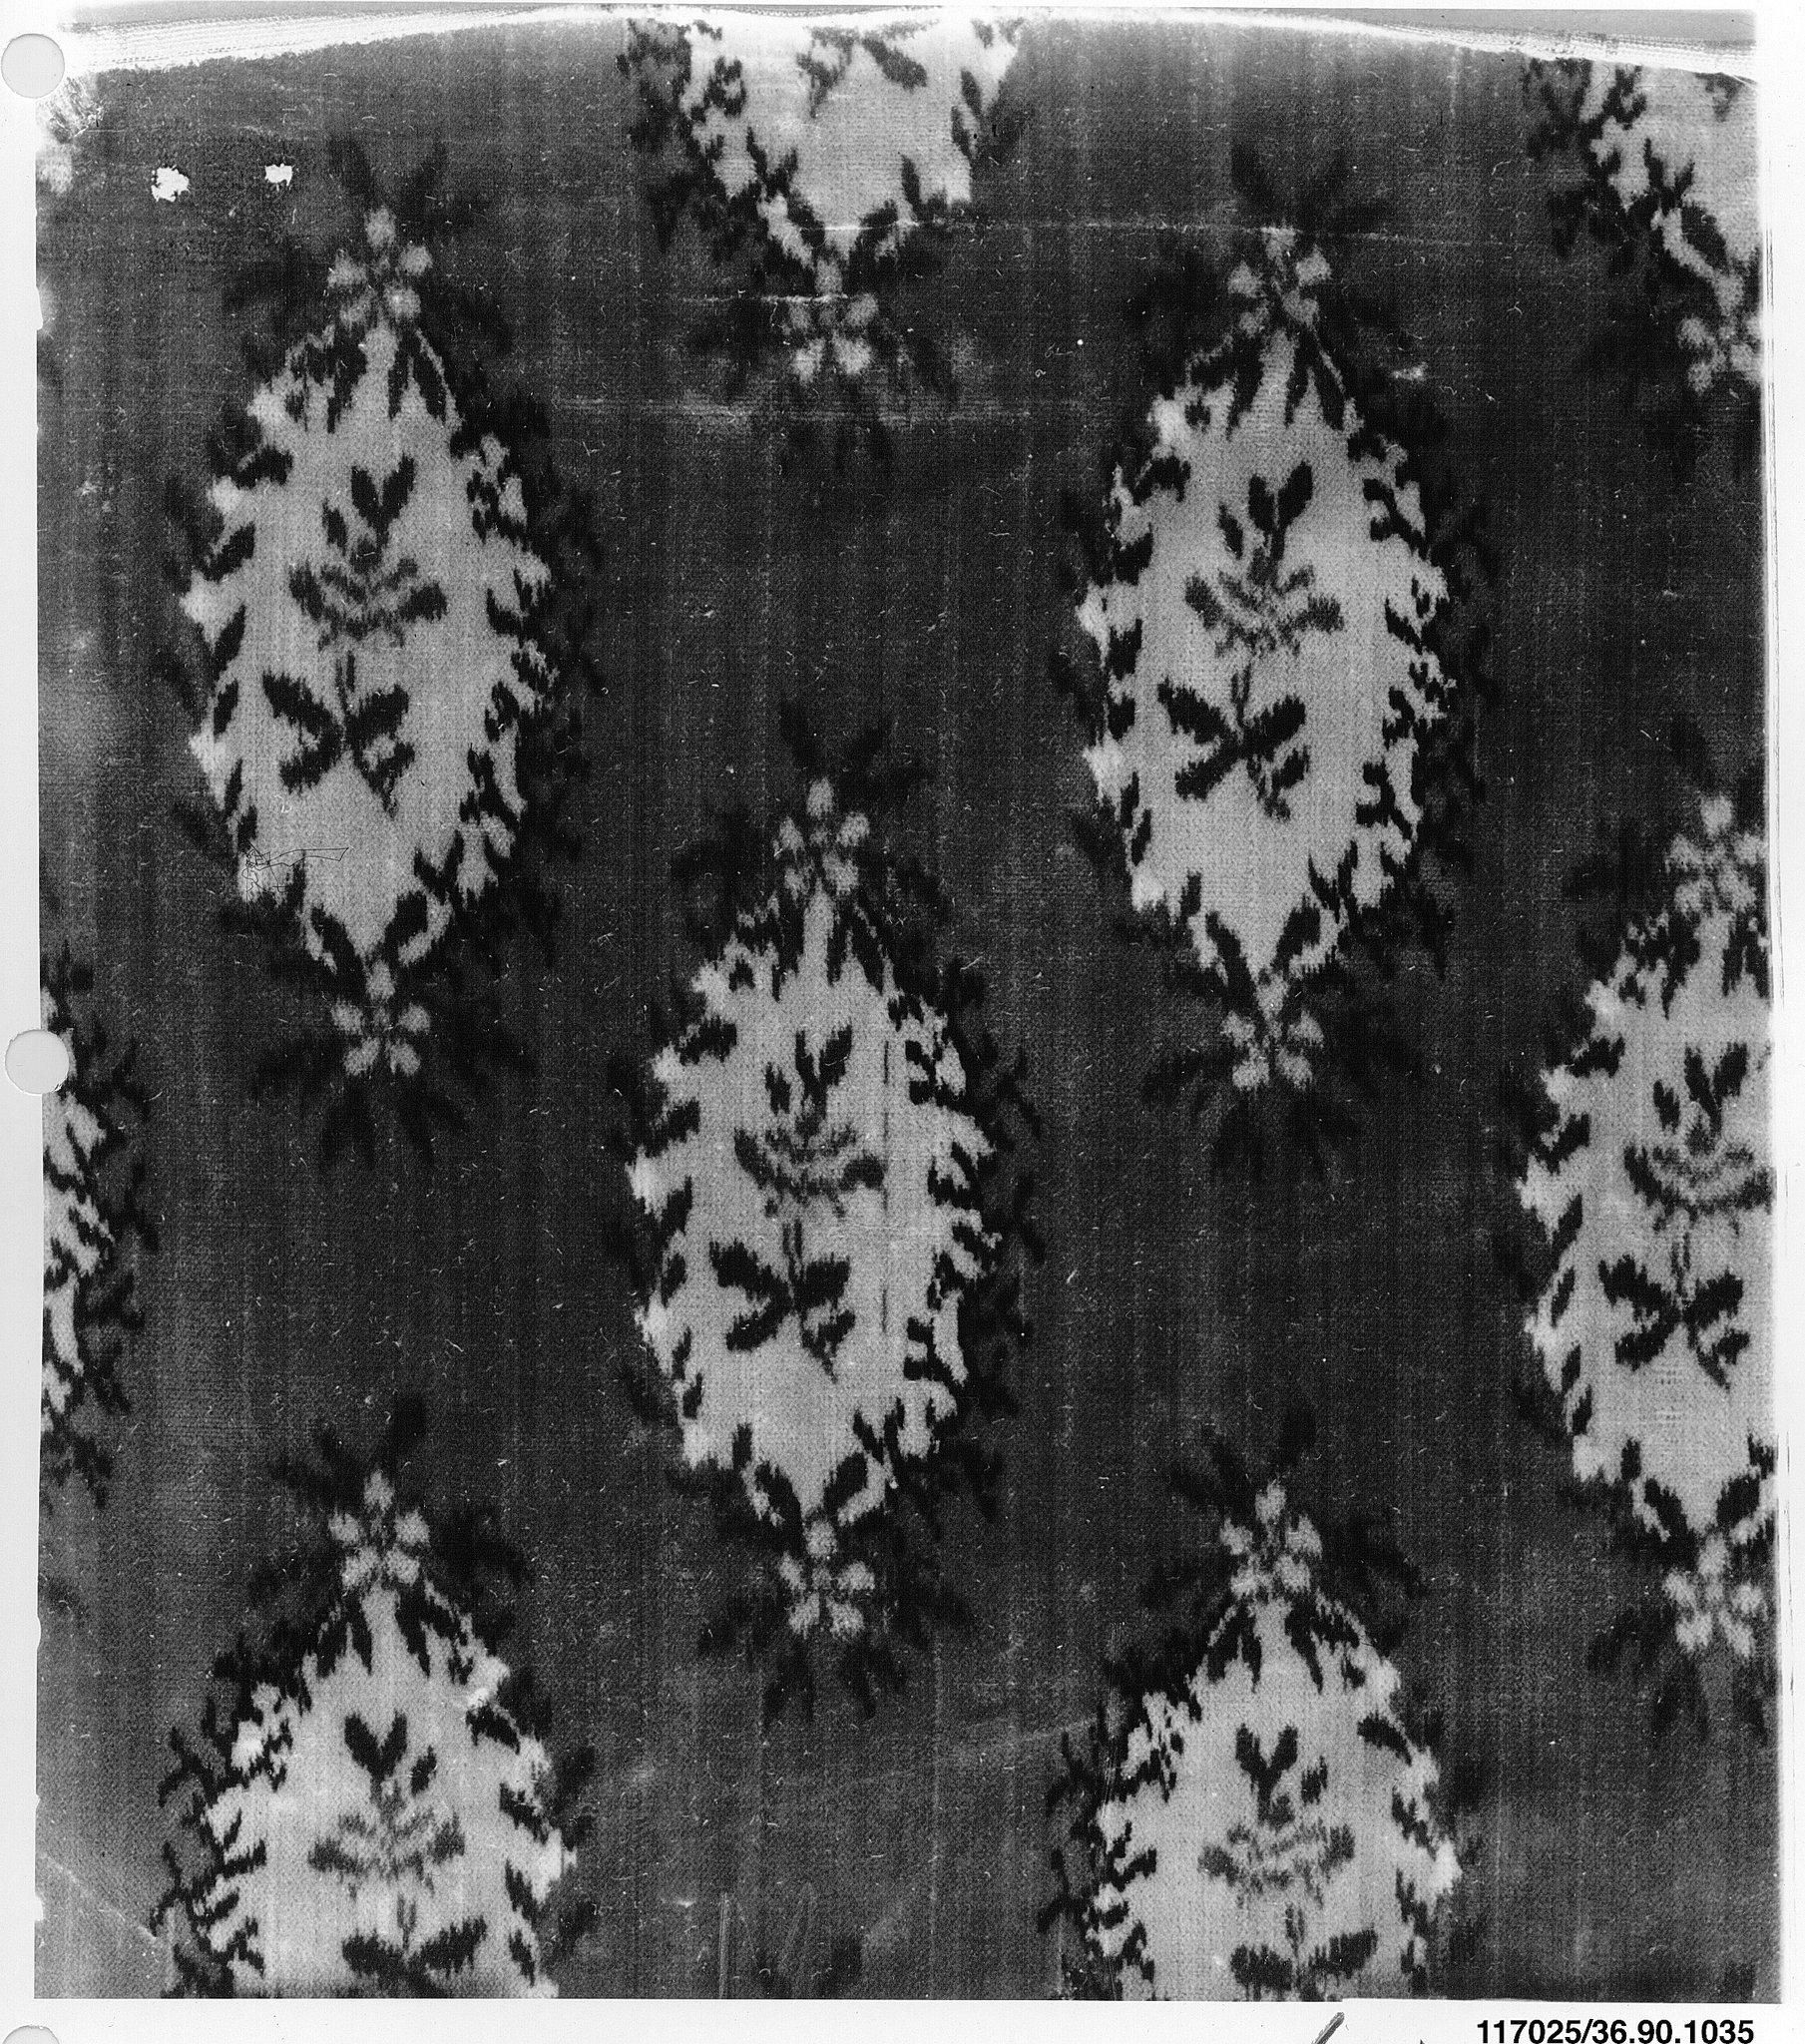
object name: border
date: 1801-1900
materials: silk